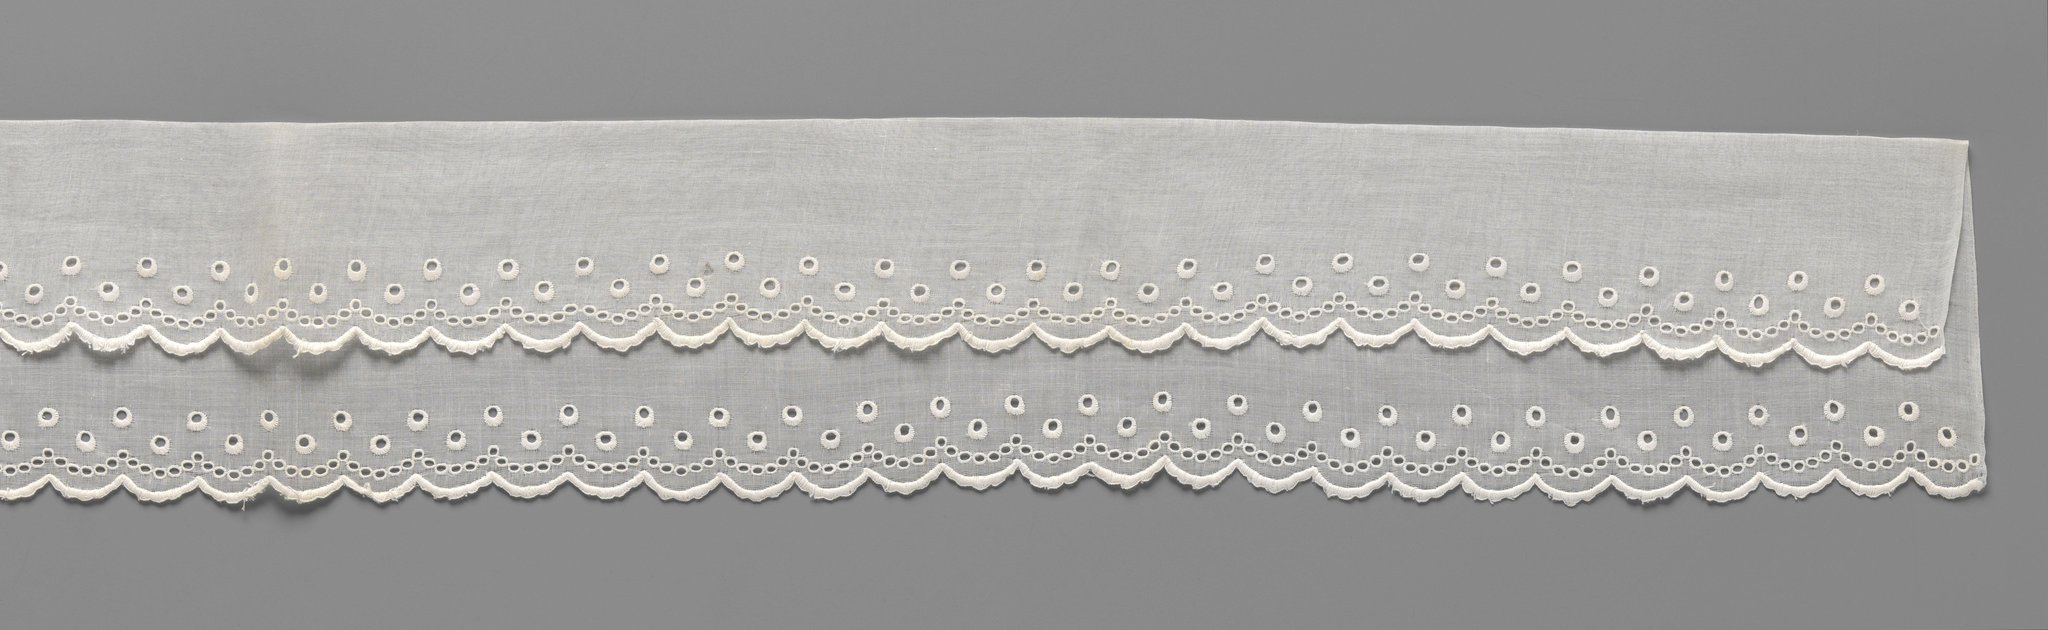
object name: strip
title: Strook batist met opengewerkte cirkeltjes boven een schulpenrand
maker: Anonymous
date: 1850-1870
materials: cotton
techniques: weave, embroidery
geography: netherlands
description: Japonstrook van glasbatist met kantborduurwerk: Engels borduurwerk. Langs boven- en onderrand loopt een schulpenrand waarboven een doorgaand 'parelsnoer' loopt van opengewerkte cirkeltjes. Boven het snoer twee verspringende rijen met grotere opengewerkte cirkeltjes.